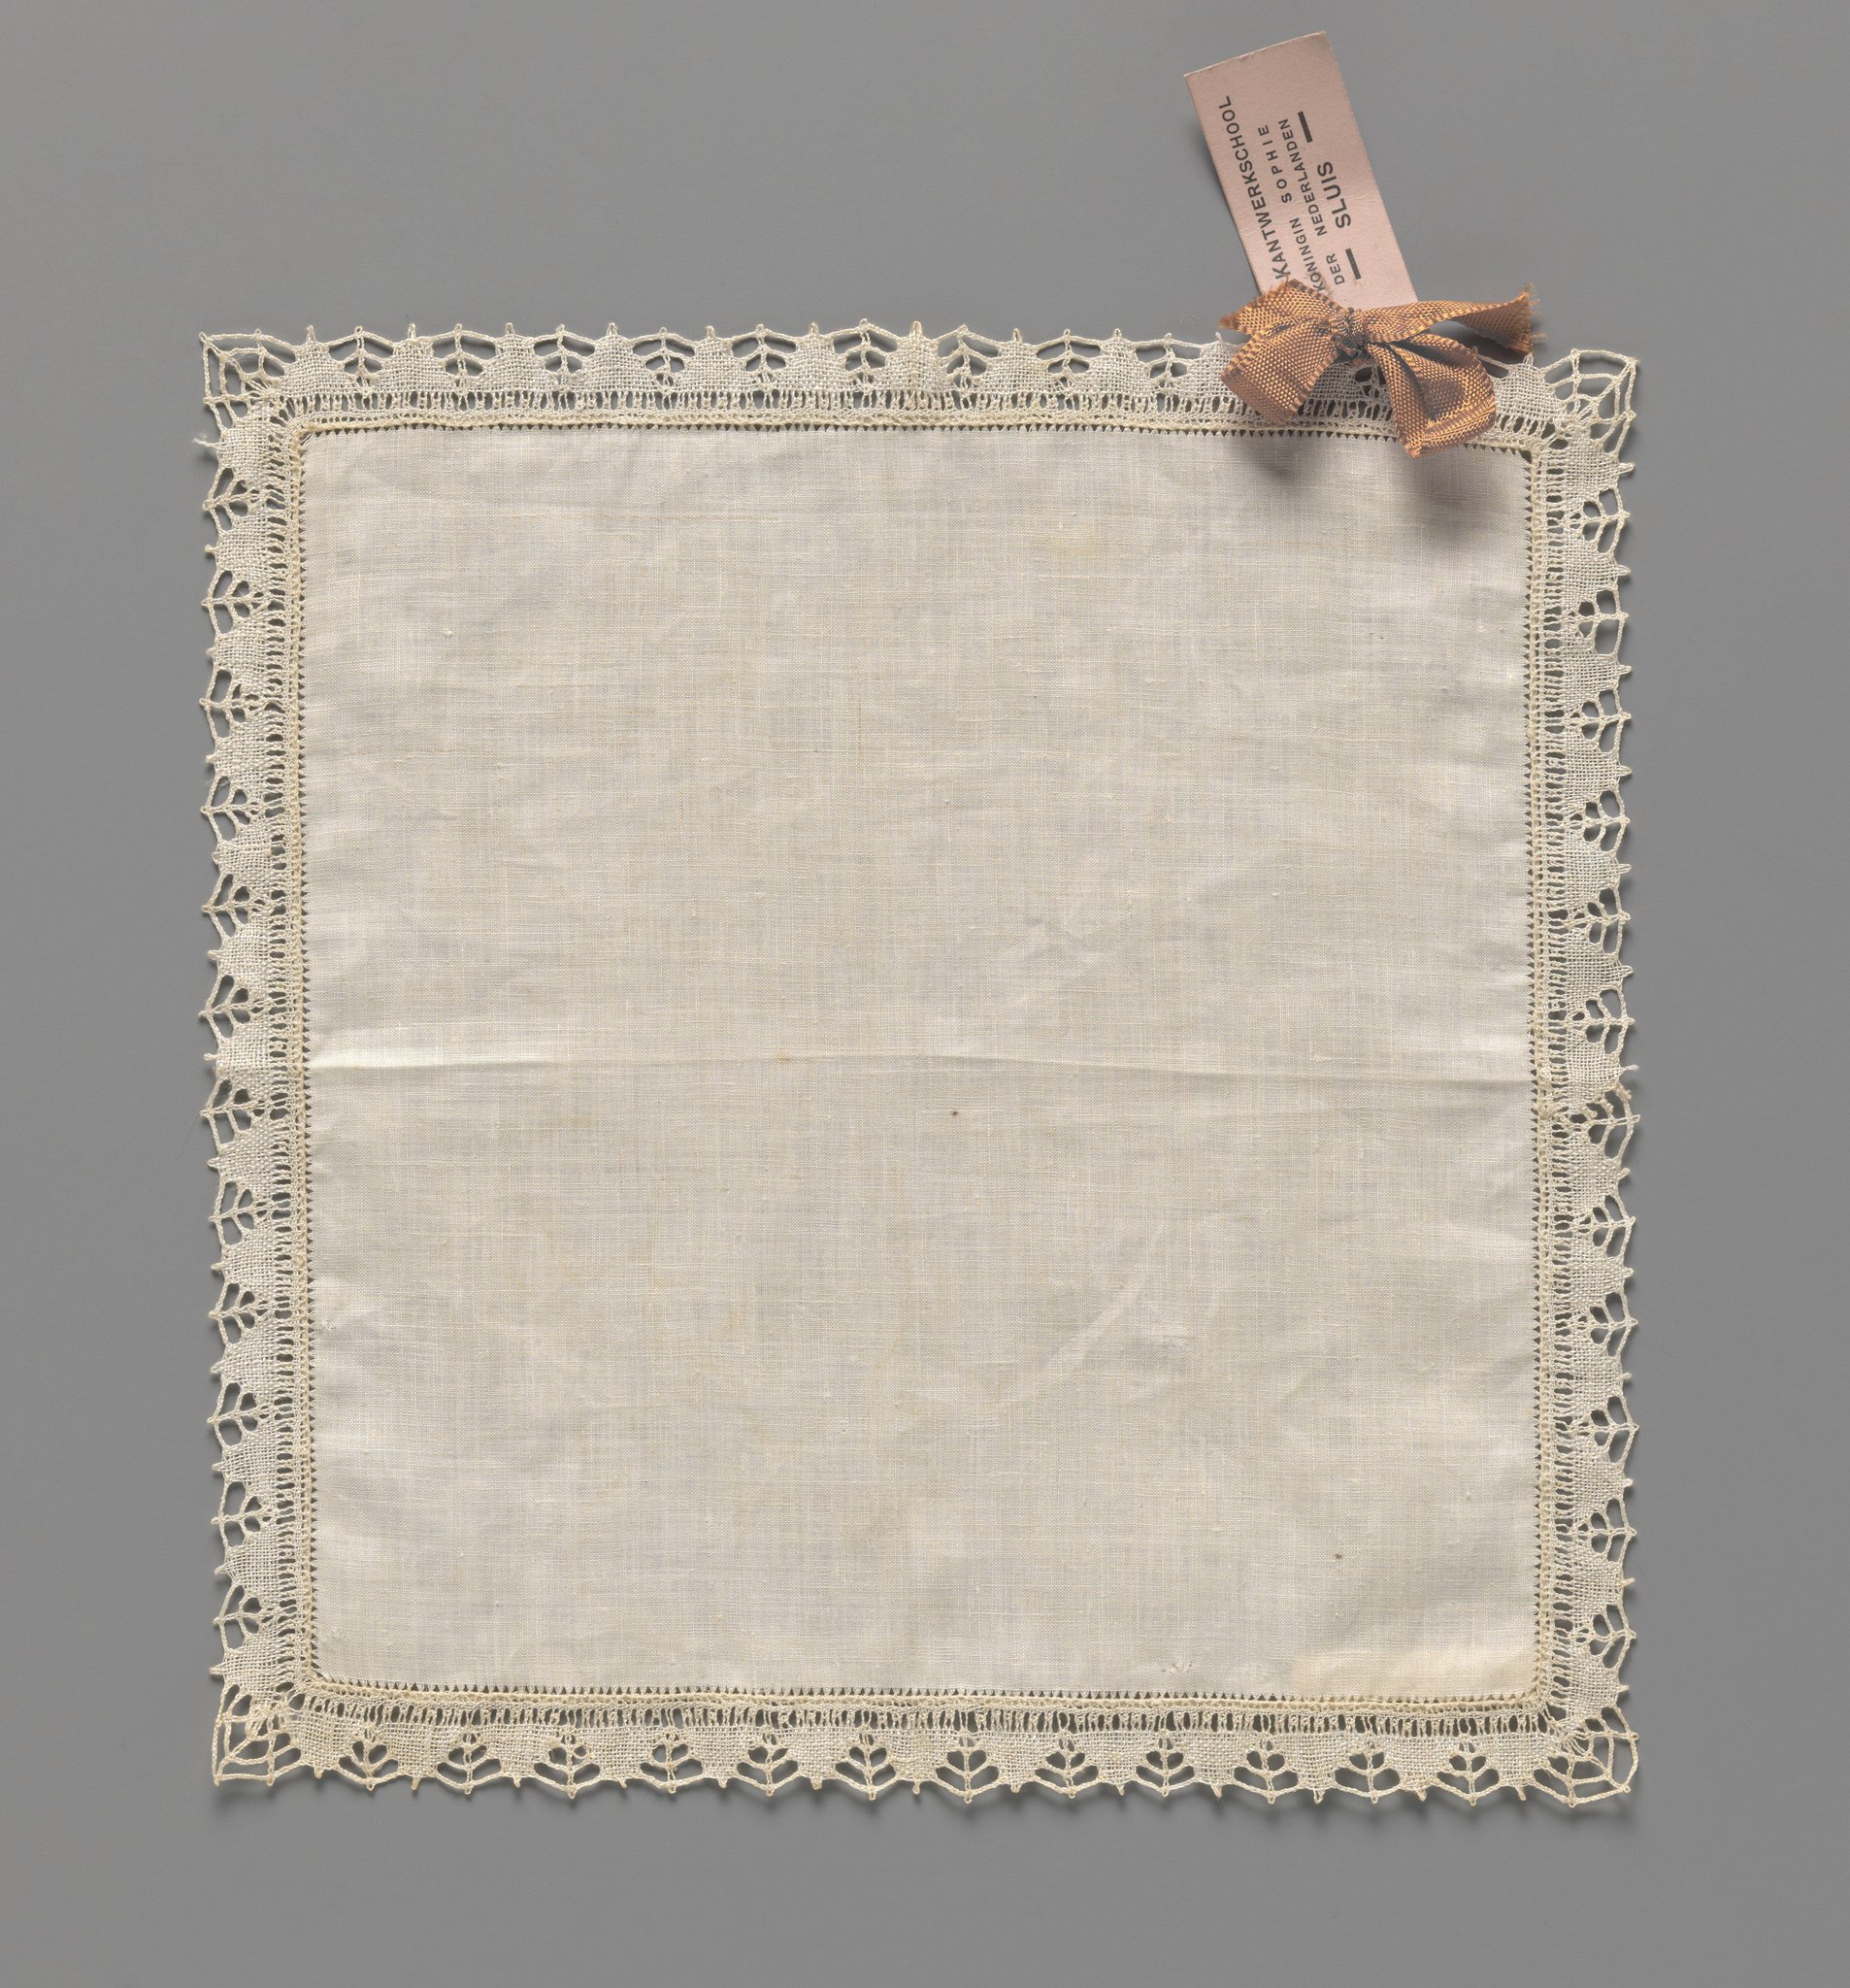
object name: womenswear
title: Zakdoek van linnen rondom afgewerkt met een rand van kloskant met driehoekjespatroon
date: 1925-1949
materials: linen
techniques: lace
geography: sluis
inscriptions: label: ‘"Kon. Kantwerkschool; Koningin Sophie; der Nederlanden; Sluis"’